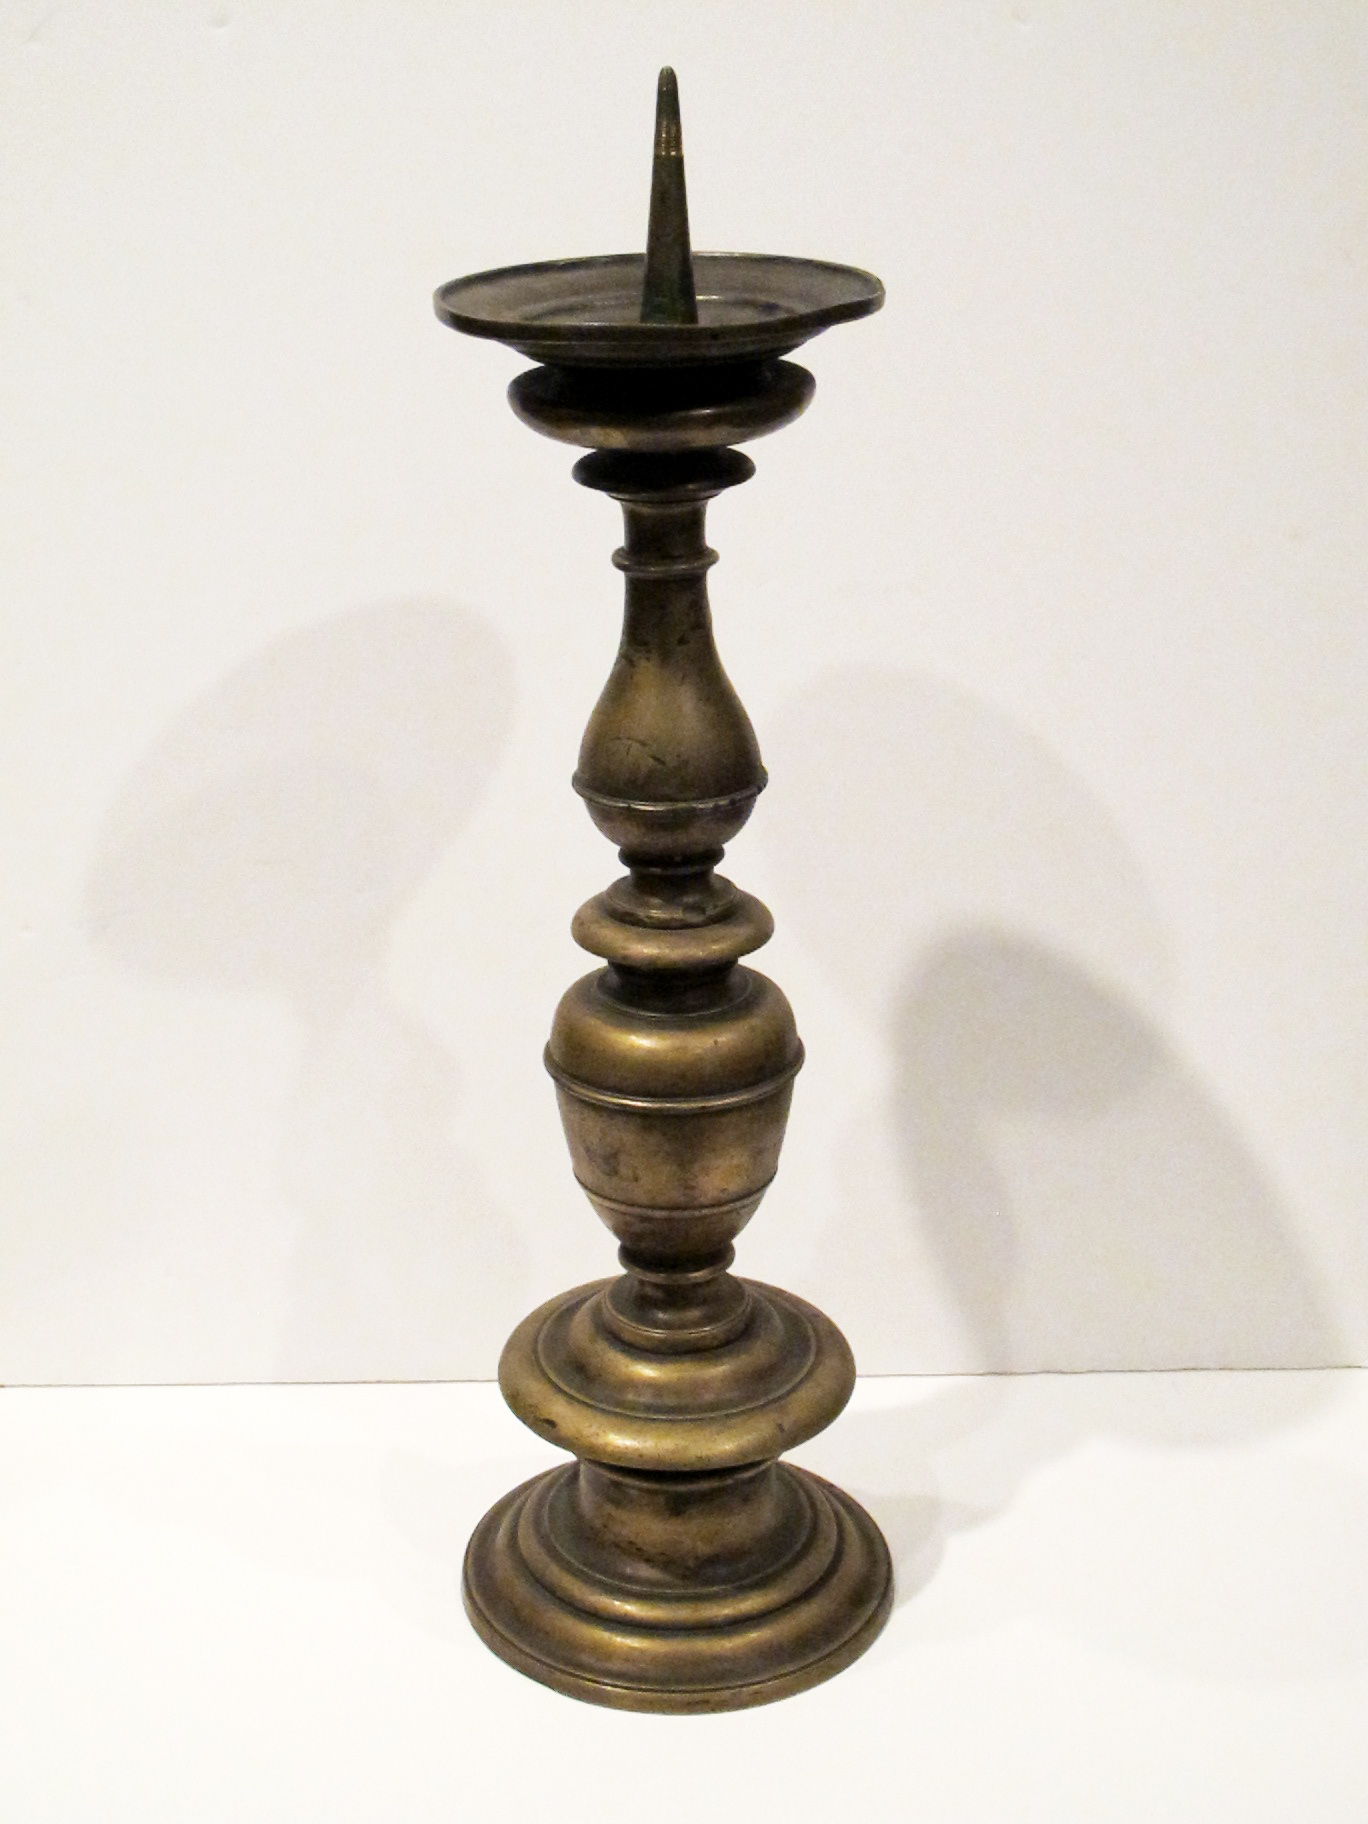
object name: candlestick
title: Candlestick (pair with .1481)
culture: european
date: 1801-1900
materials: copper alloy